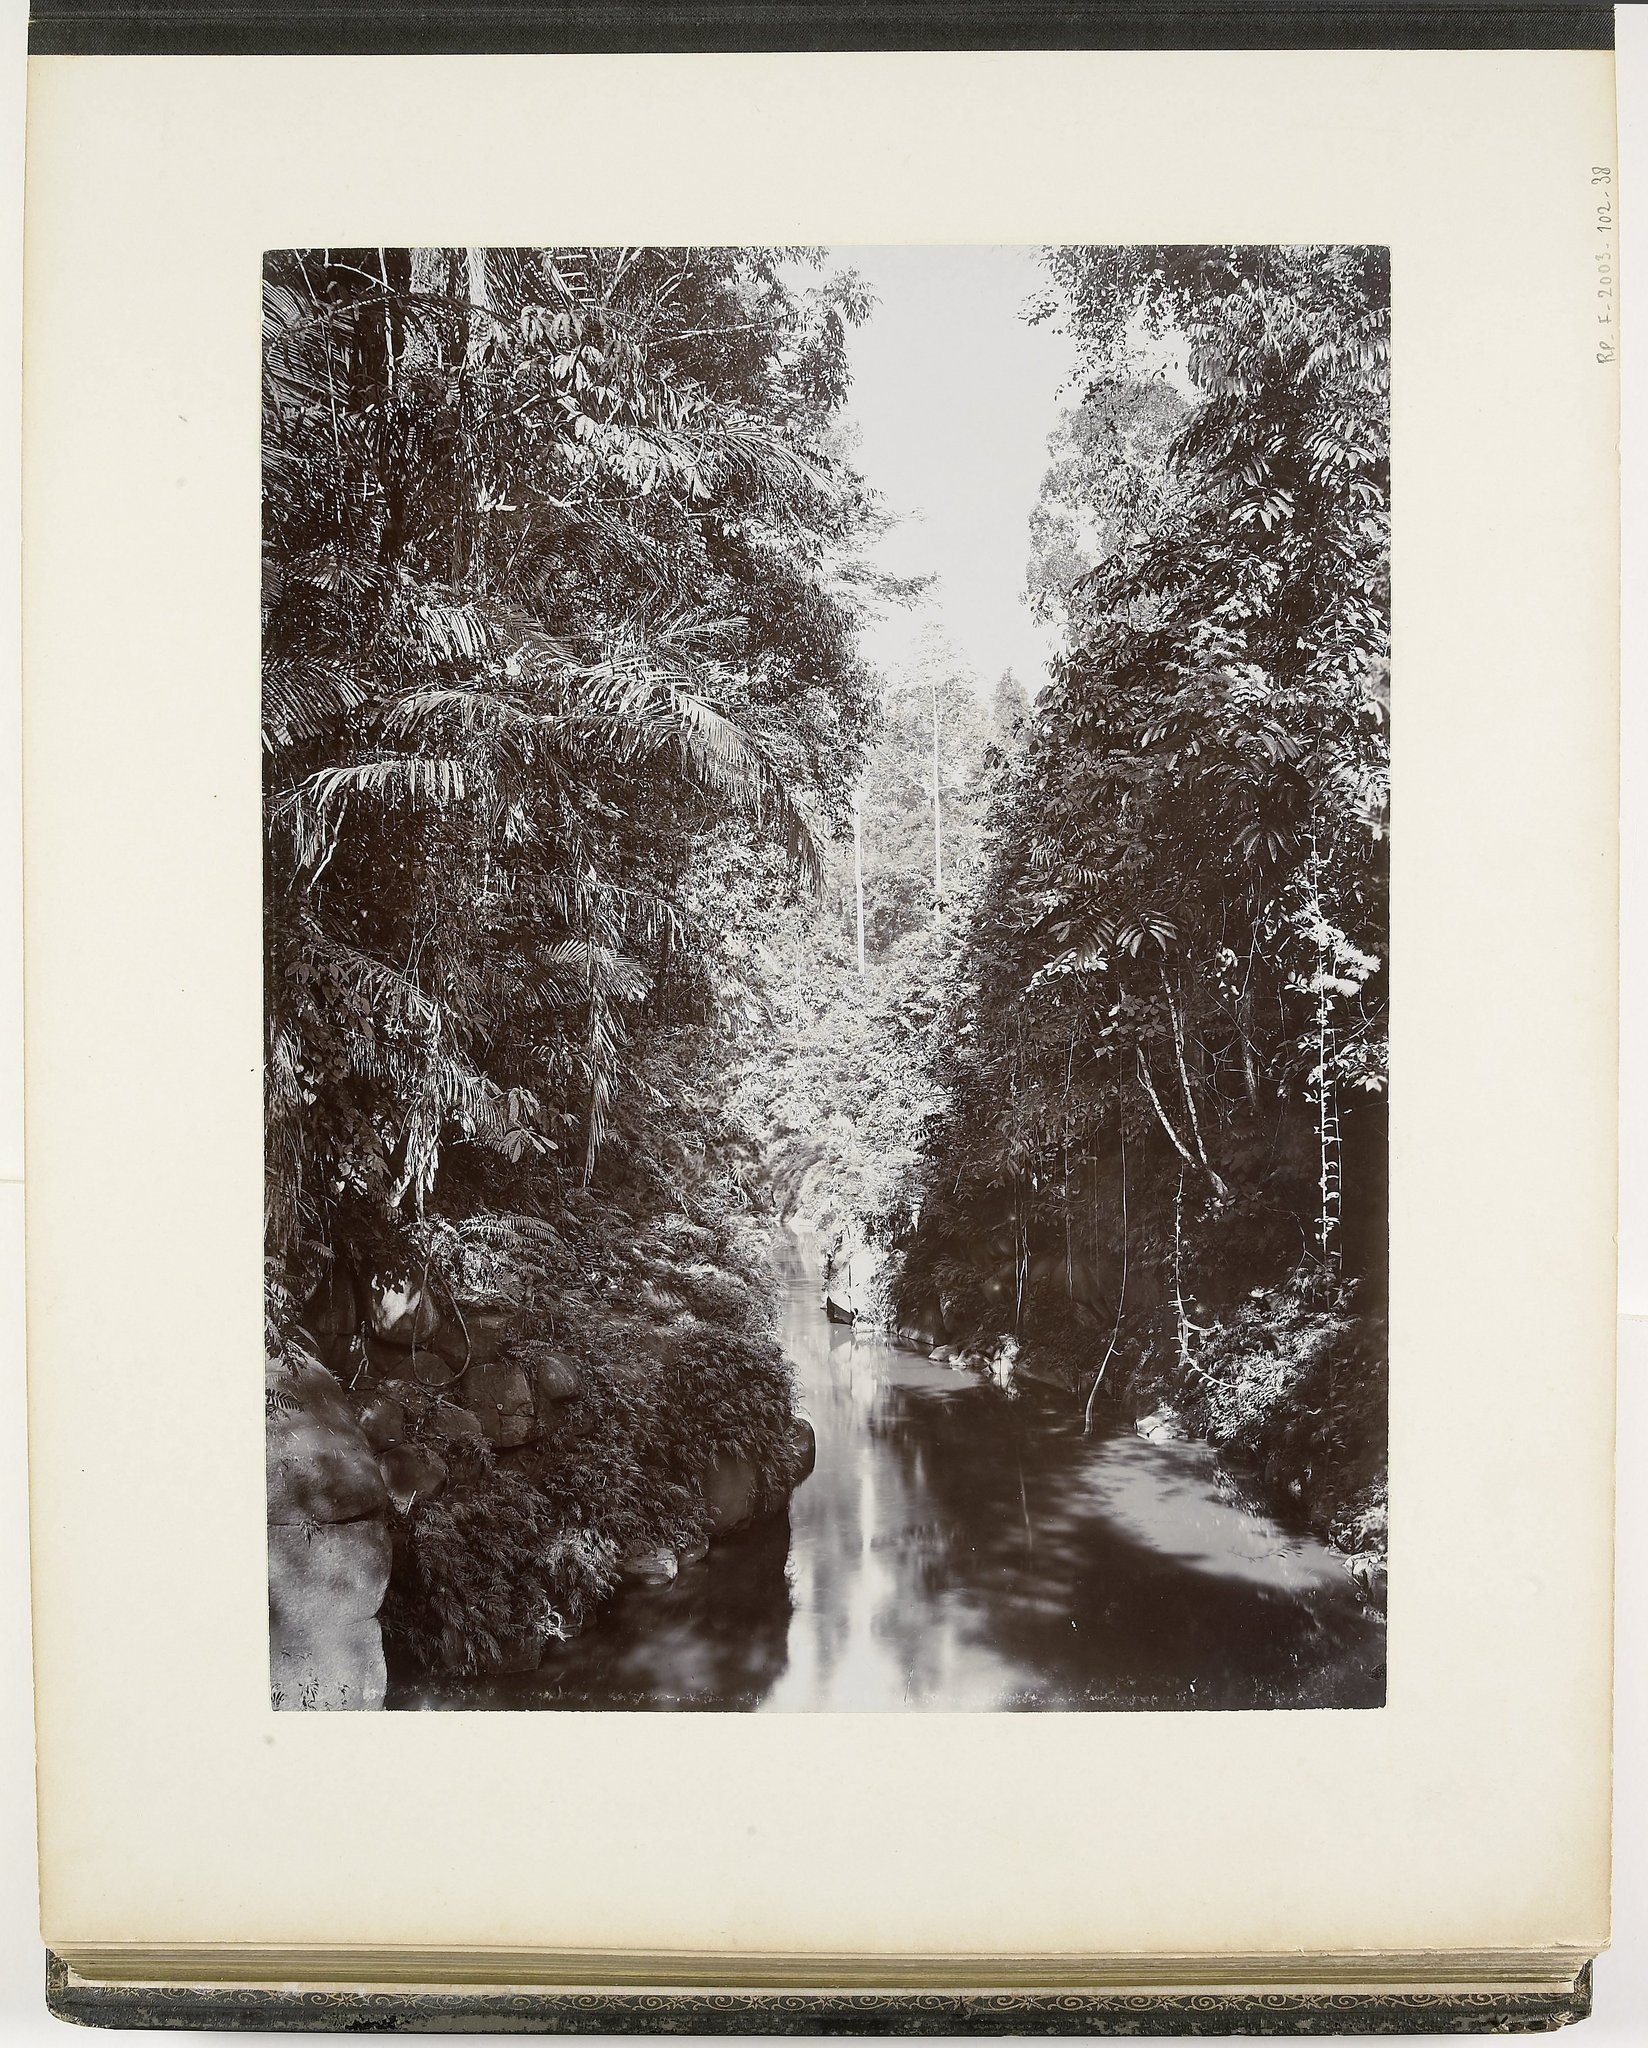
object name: photograph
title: Gezicht langs de Bloemeis rivier, Rinteh, Sumatra (Bloemeis Fluss Gg. Rinteh)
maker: carl j. kleingrothe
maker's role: fotograaf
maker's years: 1864-1925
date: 1885-1900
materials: photographic support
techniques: collodion silver print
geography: sumatra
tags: sumatra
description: Gezicht op een rivier door het oerwoud bij op Sumatra. Onderdeel van het Sumatra fotoalbum van Paul en Lucie Sandel uit 1900.